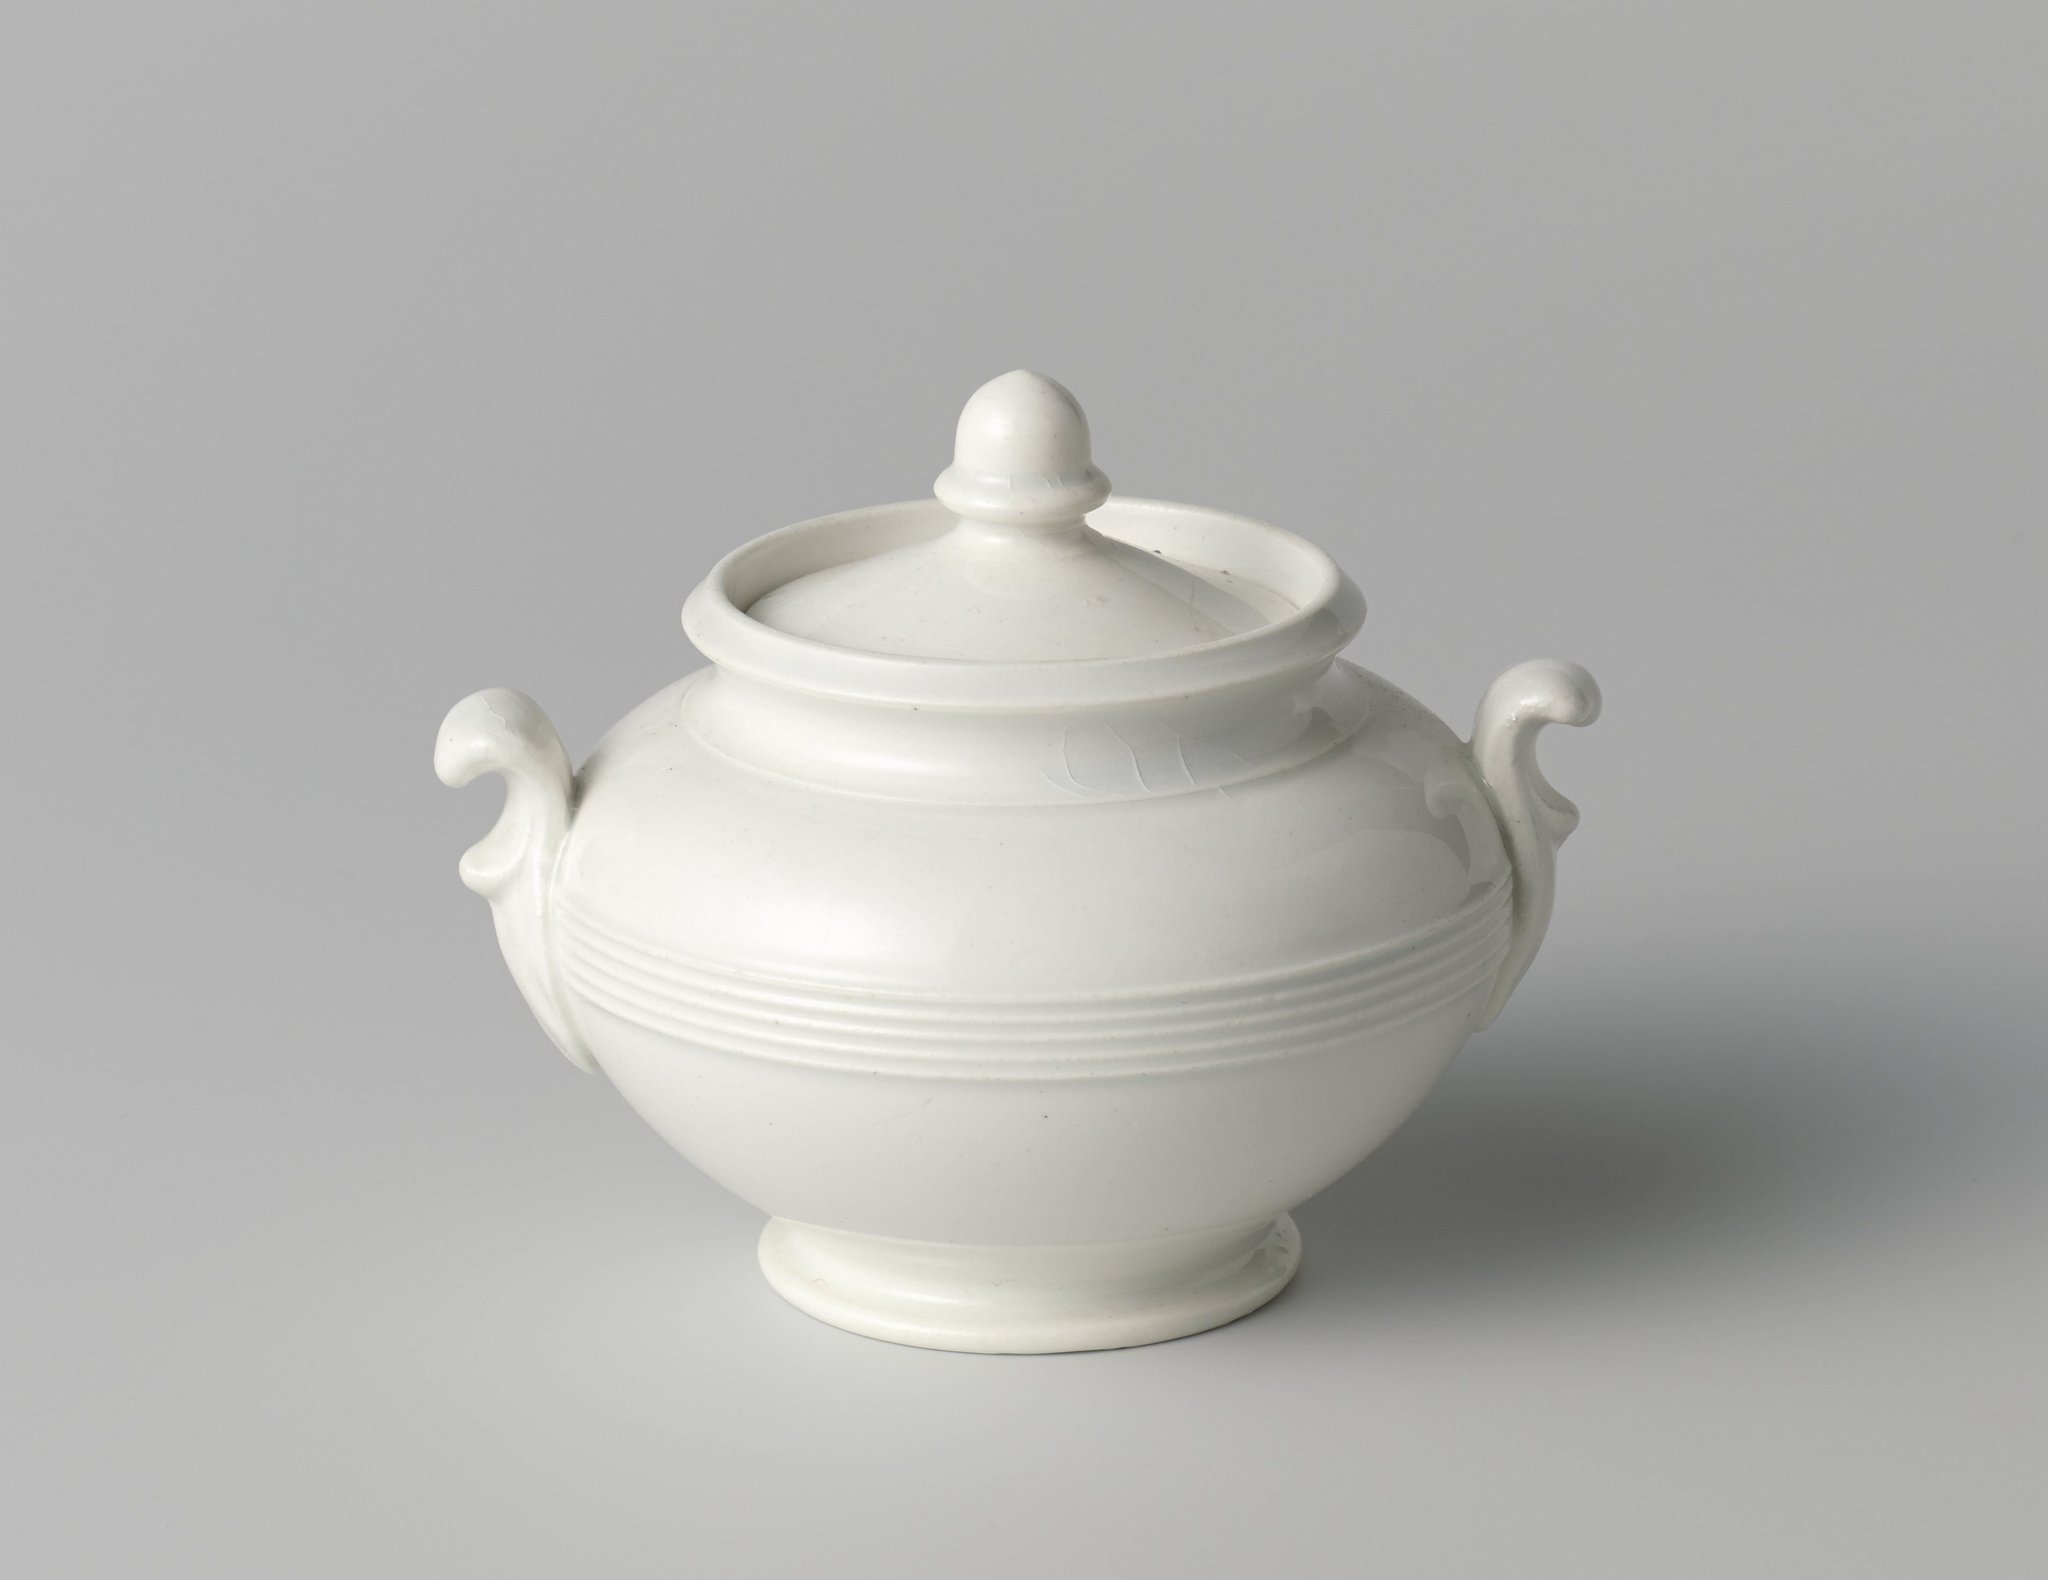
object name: sugar box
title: Suikerpot met deksel, crèmekleurig, met op de buik een band met horizontale ribbels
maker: petrus regout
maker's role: plateelbakker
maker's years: 1801-1879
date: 1801-1879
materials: creamware, earthenware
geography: maastricht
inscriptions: check stamp: ‘PR 5’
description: Suikerpot met deksel van aardewerk, creamware, met op de buik een band met horizontale ribbels.